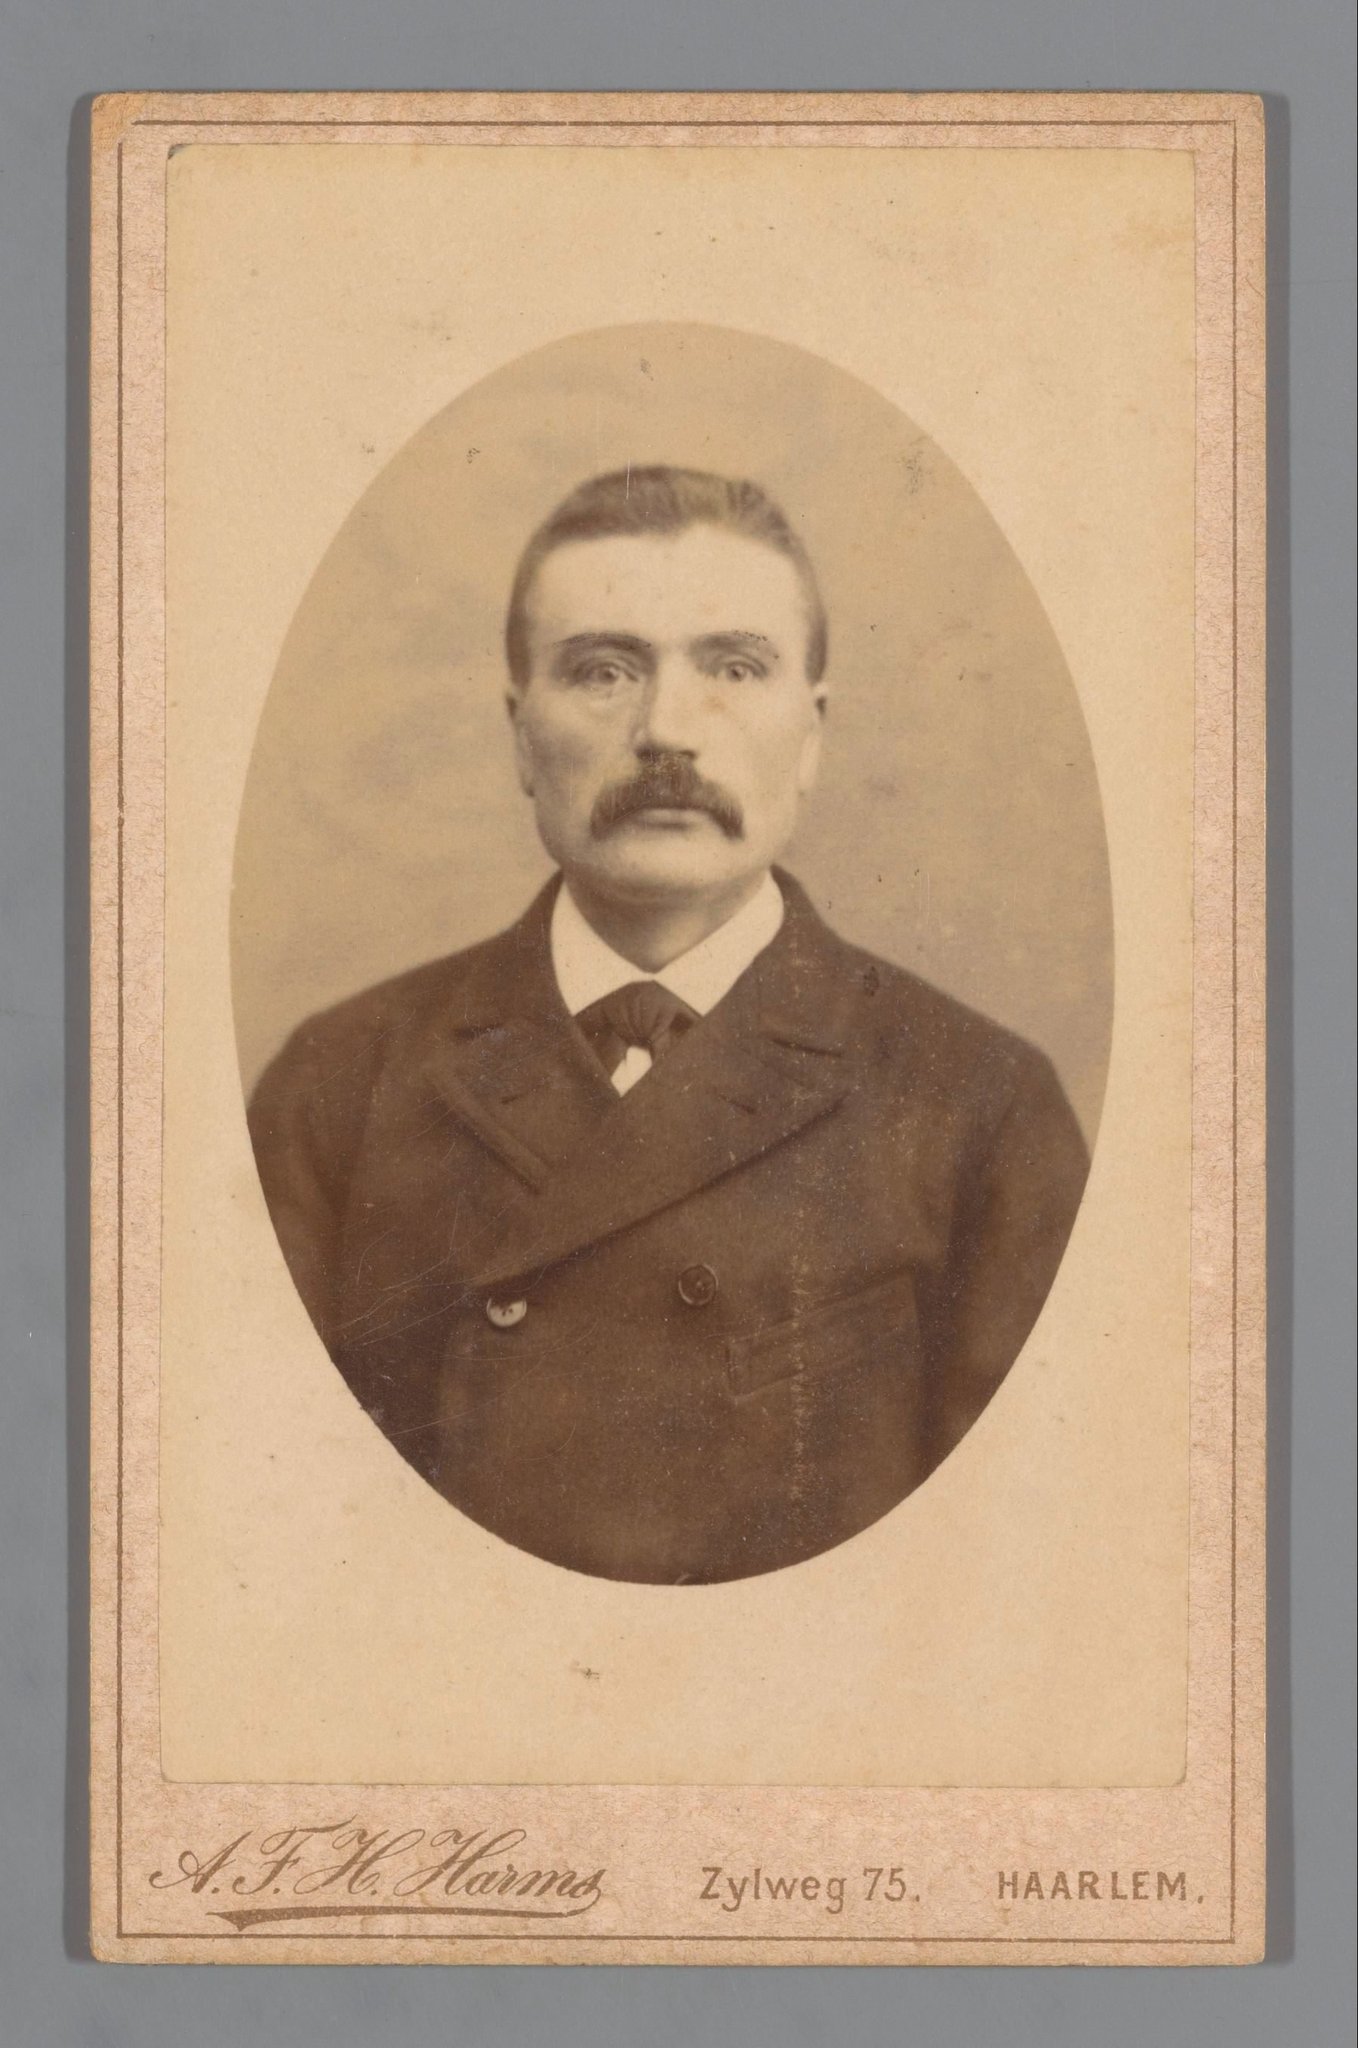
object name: photograph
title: Portret van een onbekende man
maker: august ferdinand heinrich harms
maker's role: fotograaf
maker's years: 1845-1916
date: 1884-1900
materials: cardboard, paper, photographic support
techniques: albumen print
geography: haarlem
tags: adult man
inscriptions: name: ‘A.F.H. Harms Zylweg 75. Haarlem’, name: ‘A.F.H. Harms Haarlem Zylweg 75.’